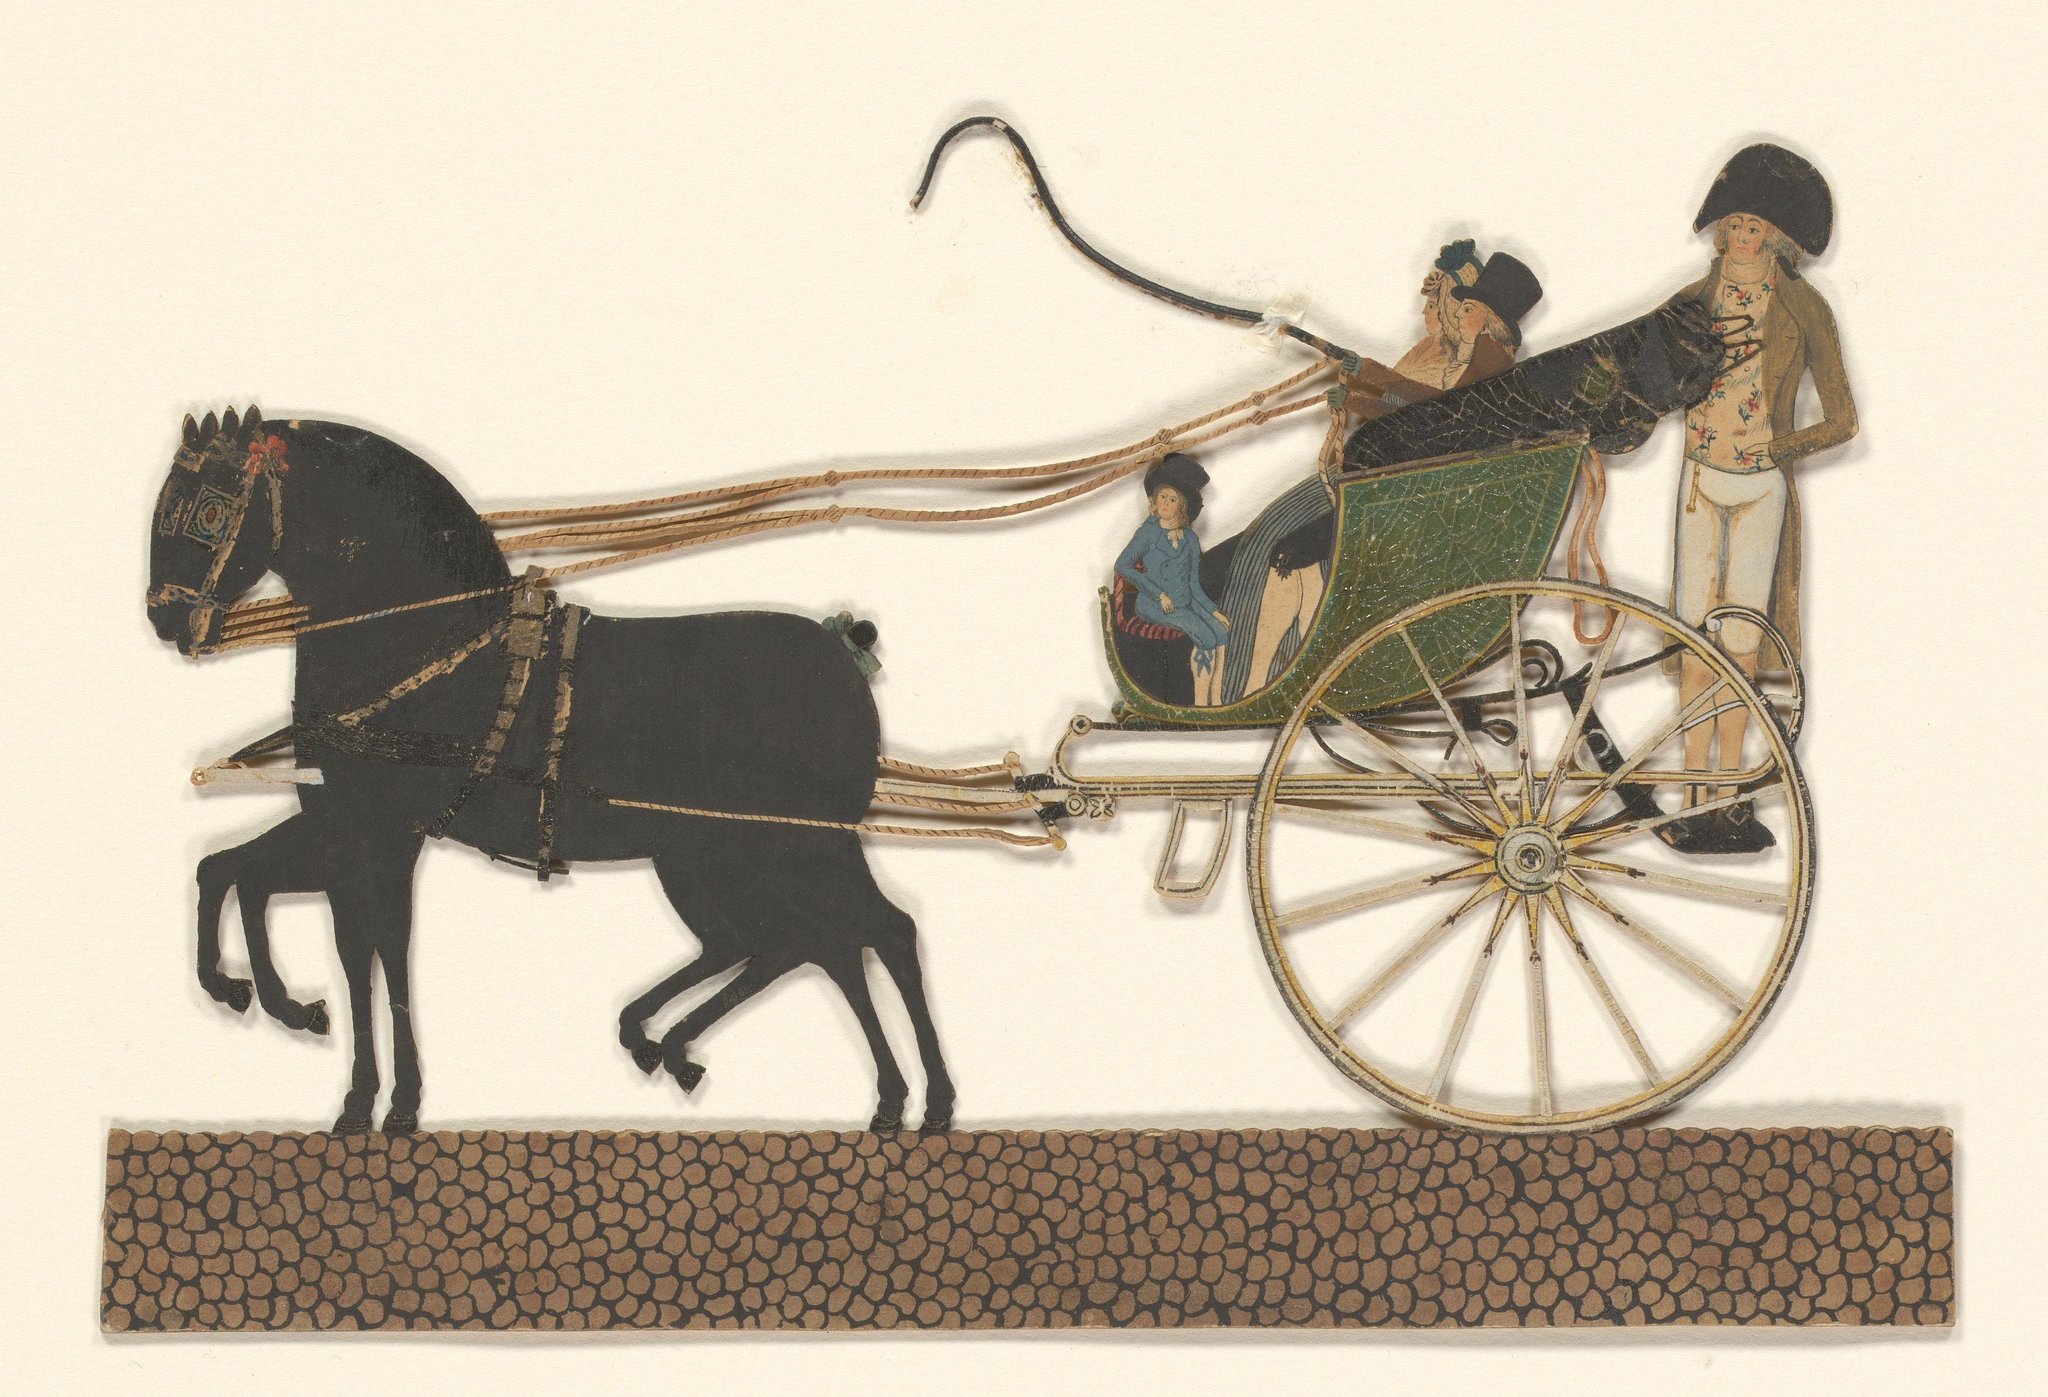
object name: clipping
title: Knipsel van calèche op twee wielen, met palfrenier, bespannen met twee paarden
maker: Anonymous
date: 1750-1850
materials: cardboard, paint, paper, watercolor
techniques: brush, pen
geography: netherlands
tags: two-wheeled vehicle drawn by two animals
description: Knipsel van een calèche op twee wielen waarin een man, een vrouw en jongen. Met palfrenier en bespannen met twee paard. Knipsel van beschilderd karton.